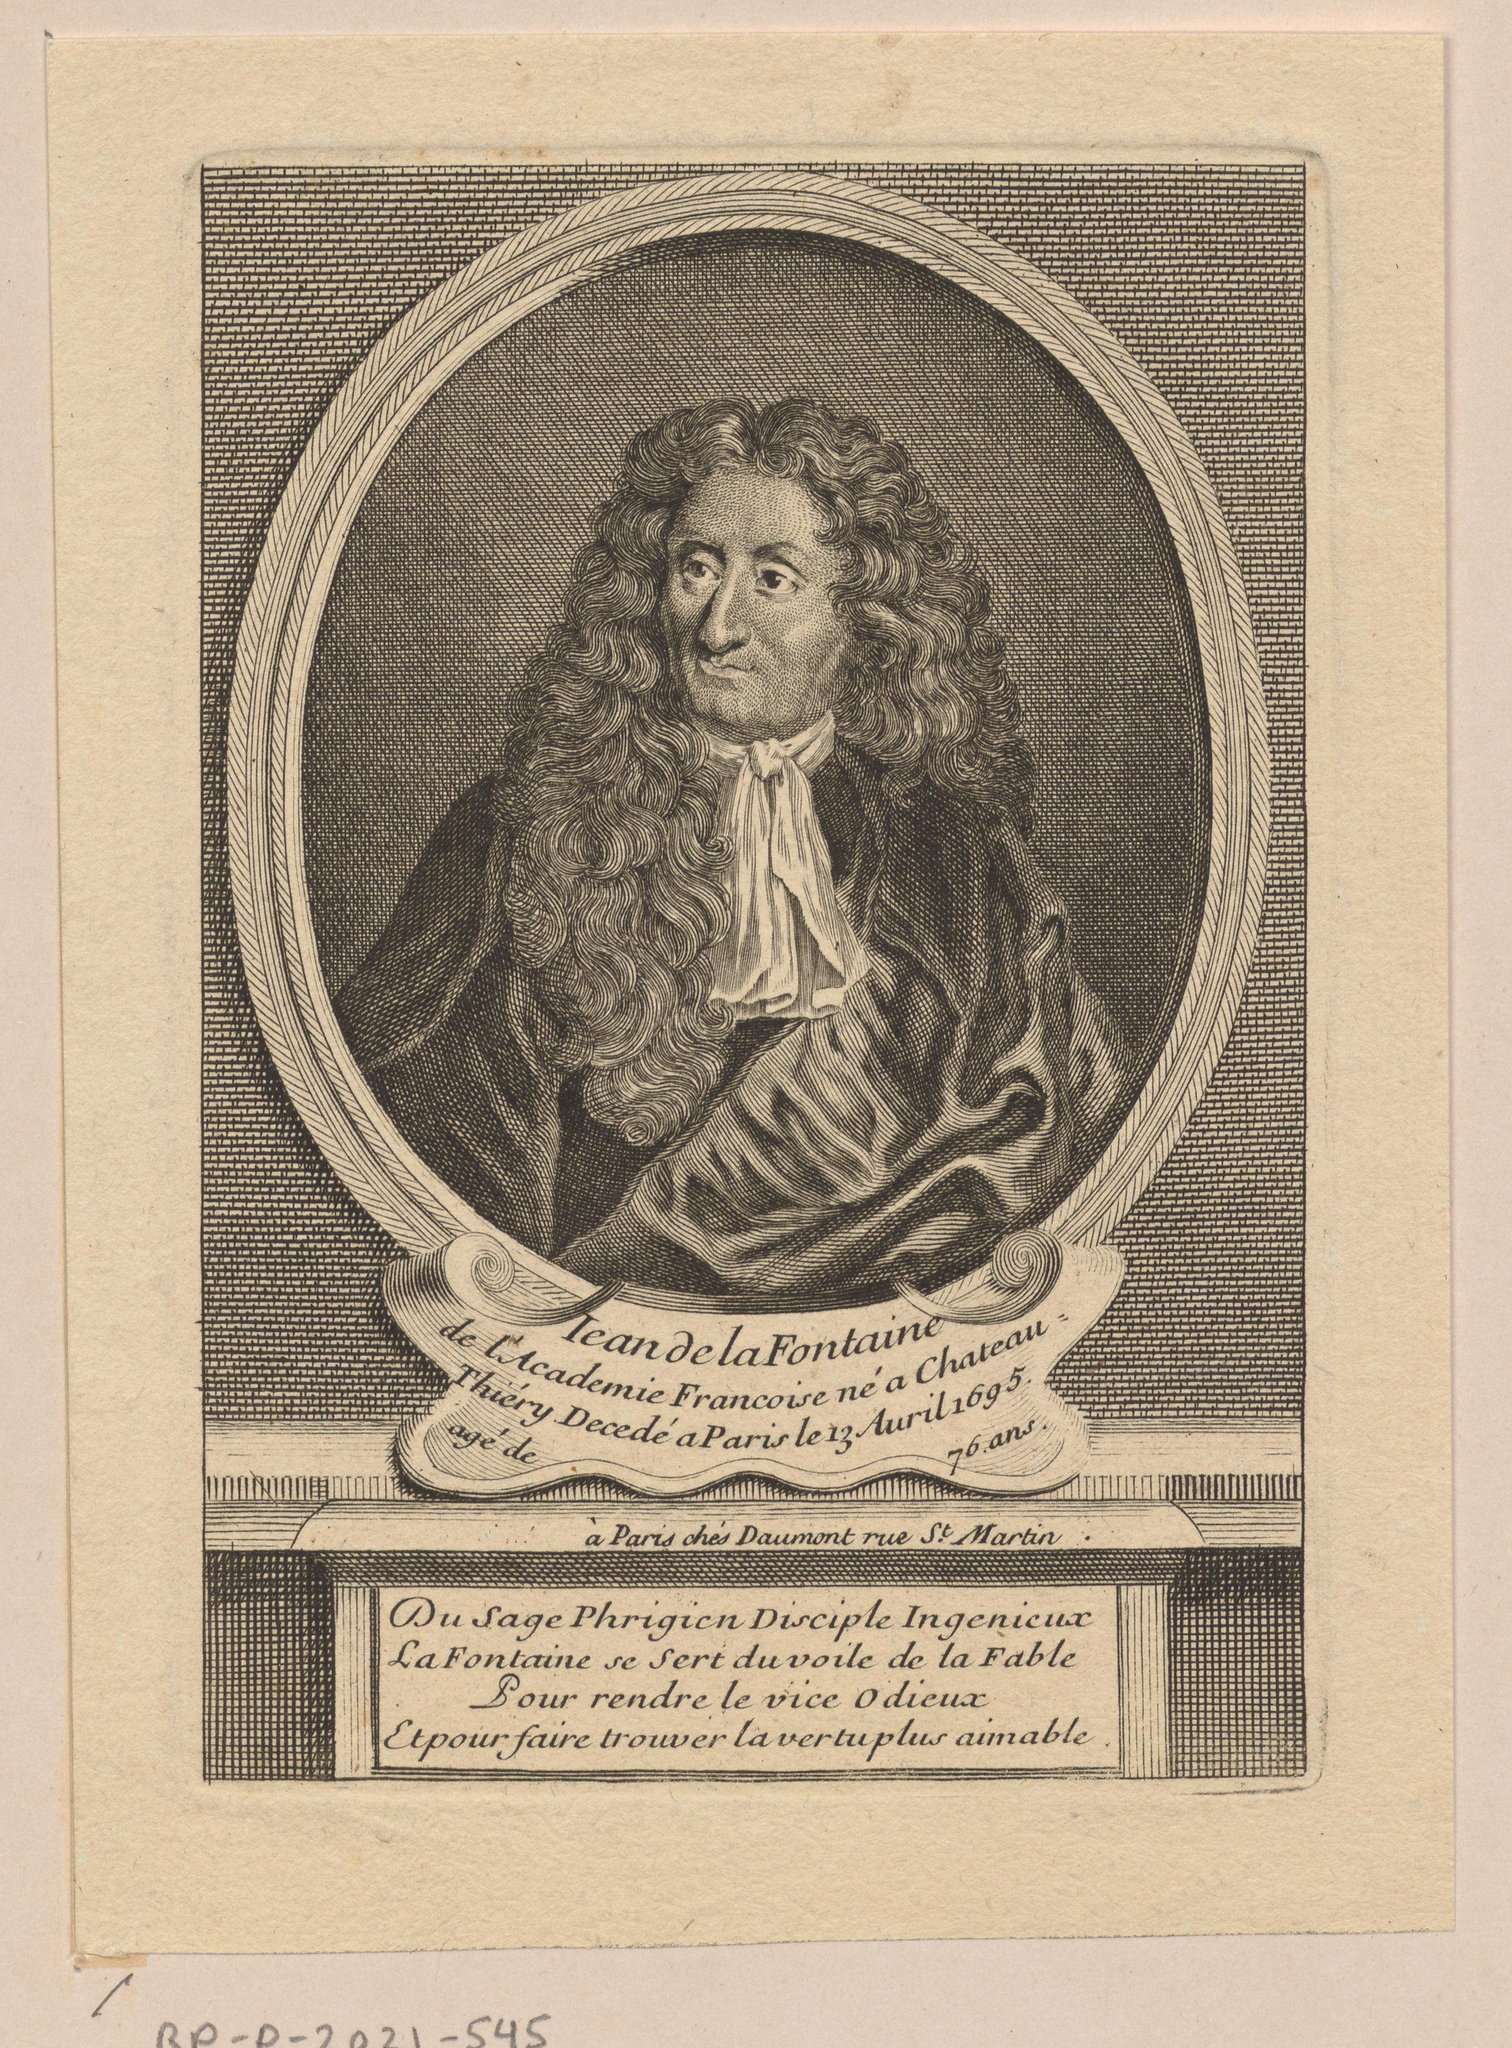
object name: print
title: Portret van Jean de La Fontaine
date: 1760-1775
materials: paper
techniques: engraving, etching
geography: france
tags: paris, jean de la fontaine, ornament ~ medallion, historical persons, portrait of a writer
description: Met Frans onderschrift en vierregelig Frans vers onder het portret.